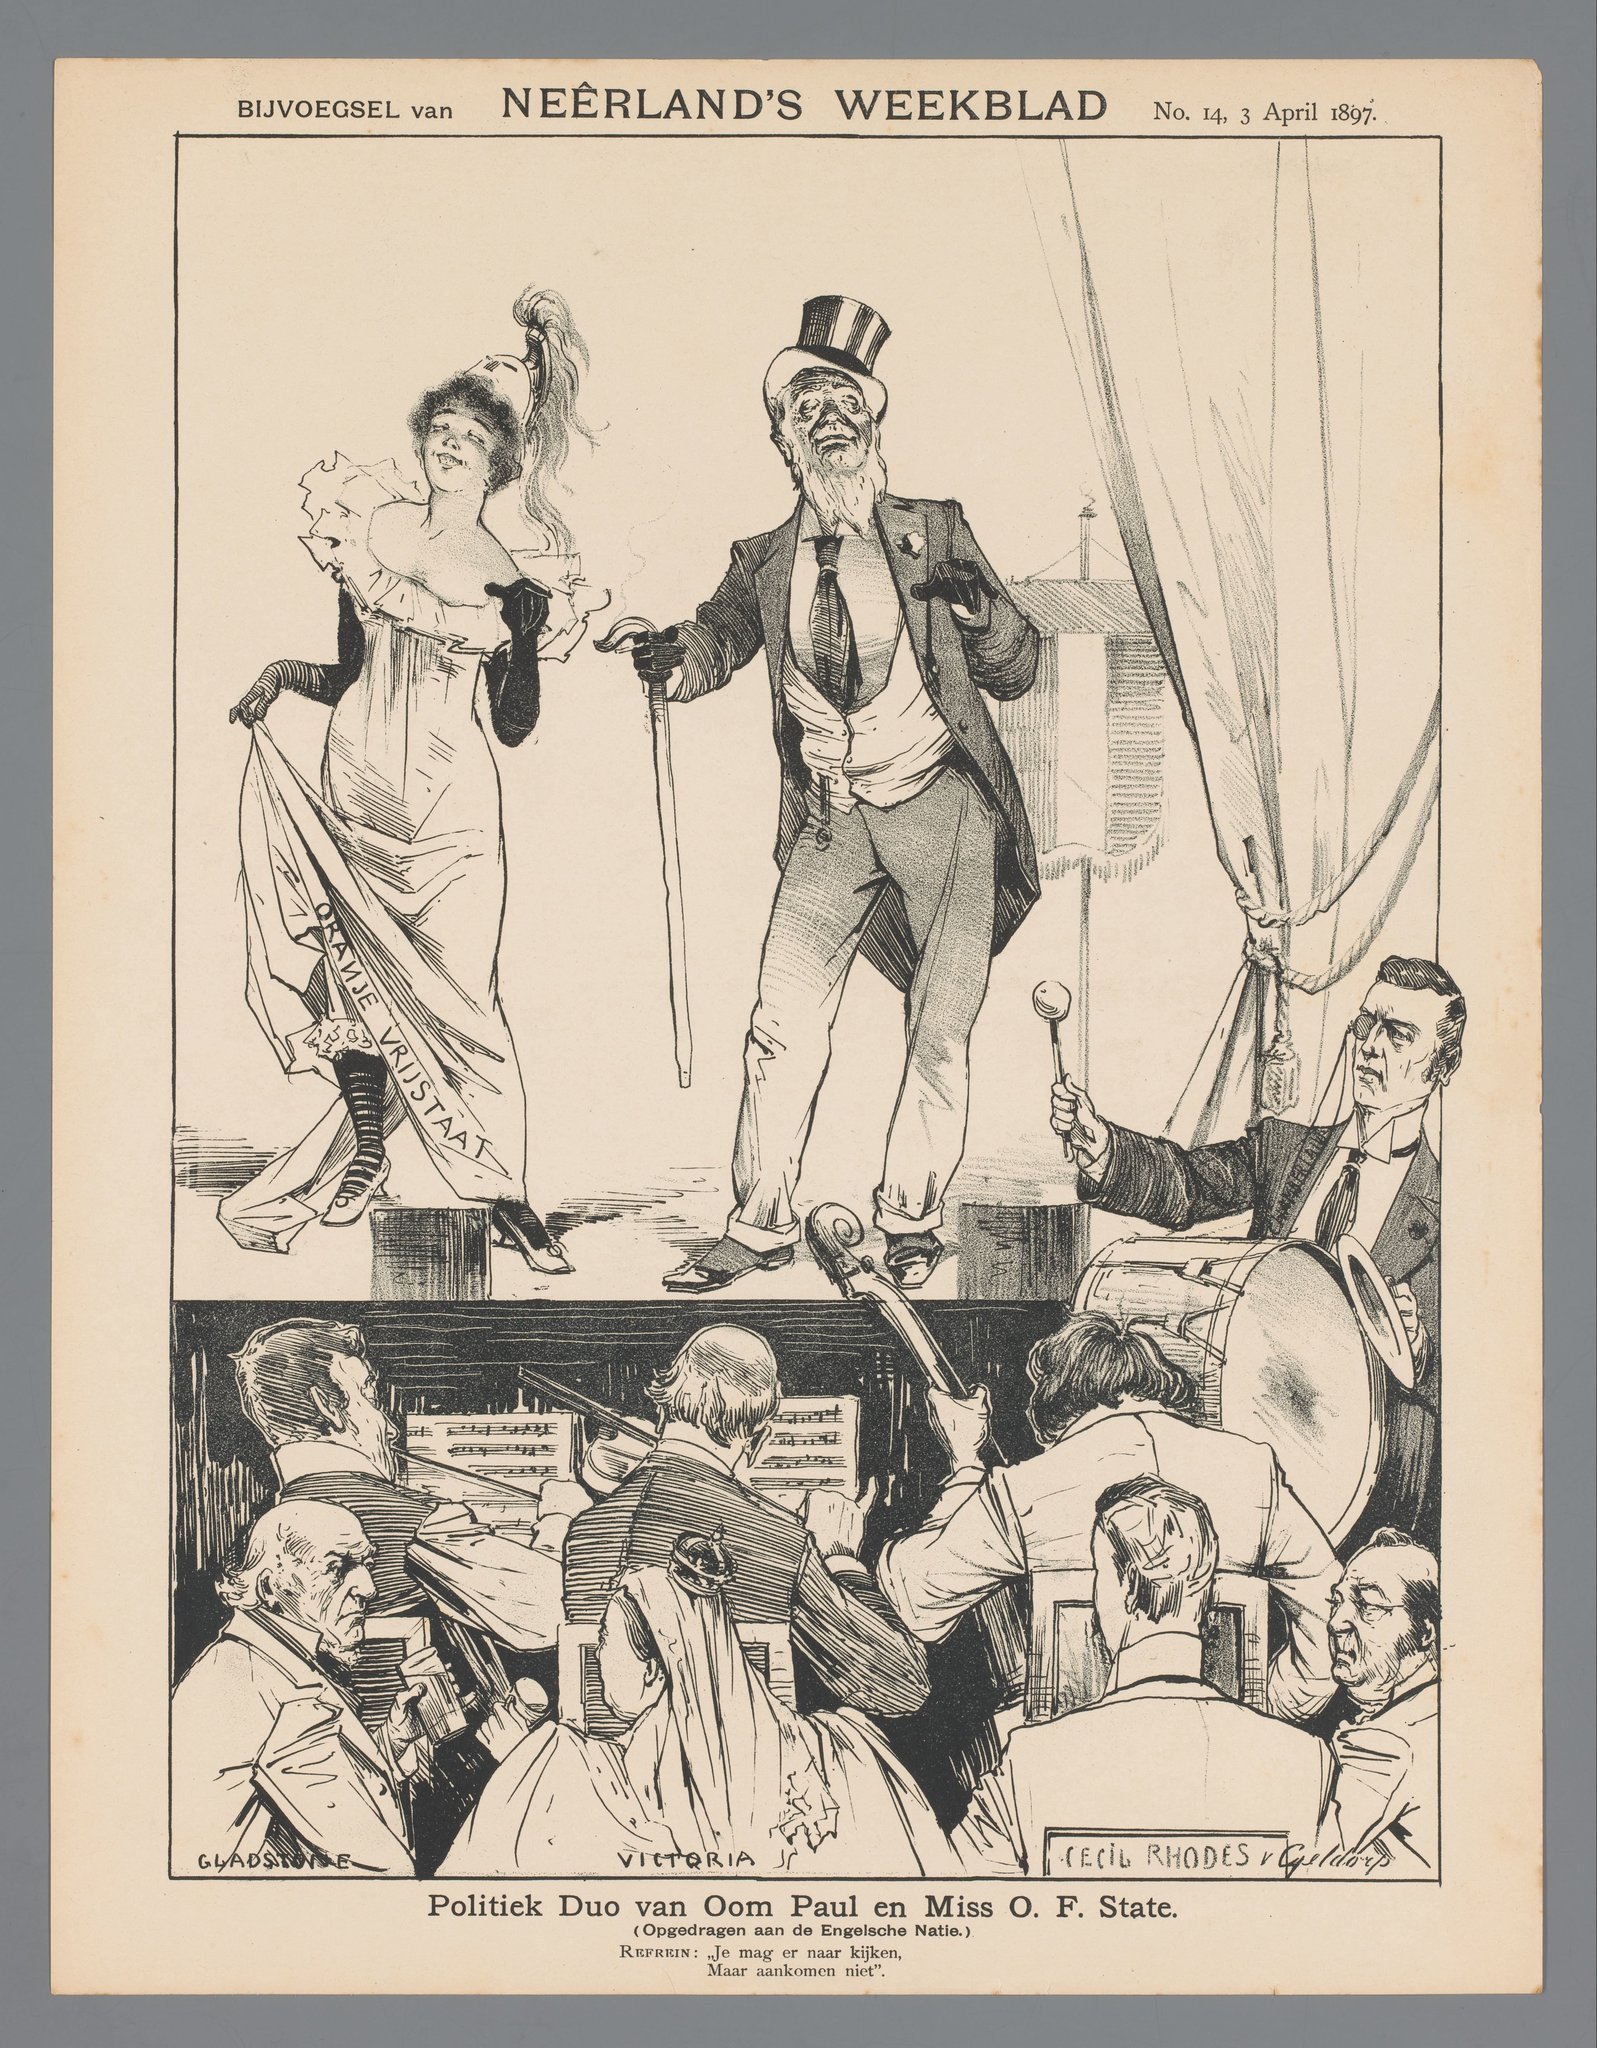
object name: cartoon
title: Politiek Duo van Oom Paul en Miss O.F. State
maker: petrus van geldorp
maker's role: draughtsman, print maker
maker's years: 1872-1939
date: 1897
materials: paper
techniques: lithograph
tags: victoria (koningin van het verenigd koninkrijk en keizerin van india), liverpool, politician, large group of musicians, orchestra, historical persons, political caricatures and satires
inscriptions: date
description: Prent uit het bijvoegsel van: Neêrland’s Weekblad, nr. 14, 3 april 1897.